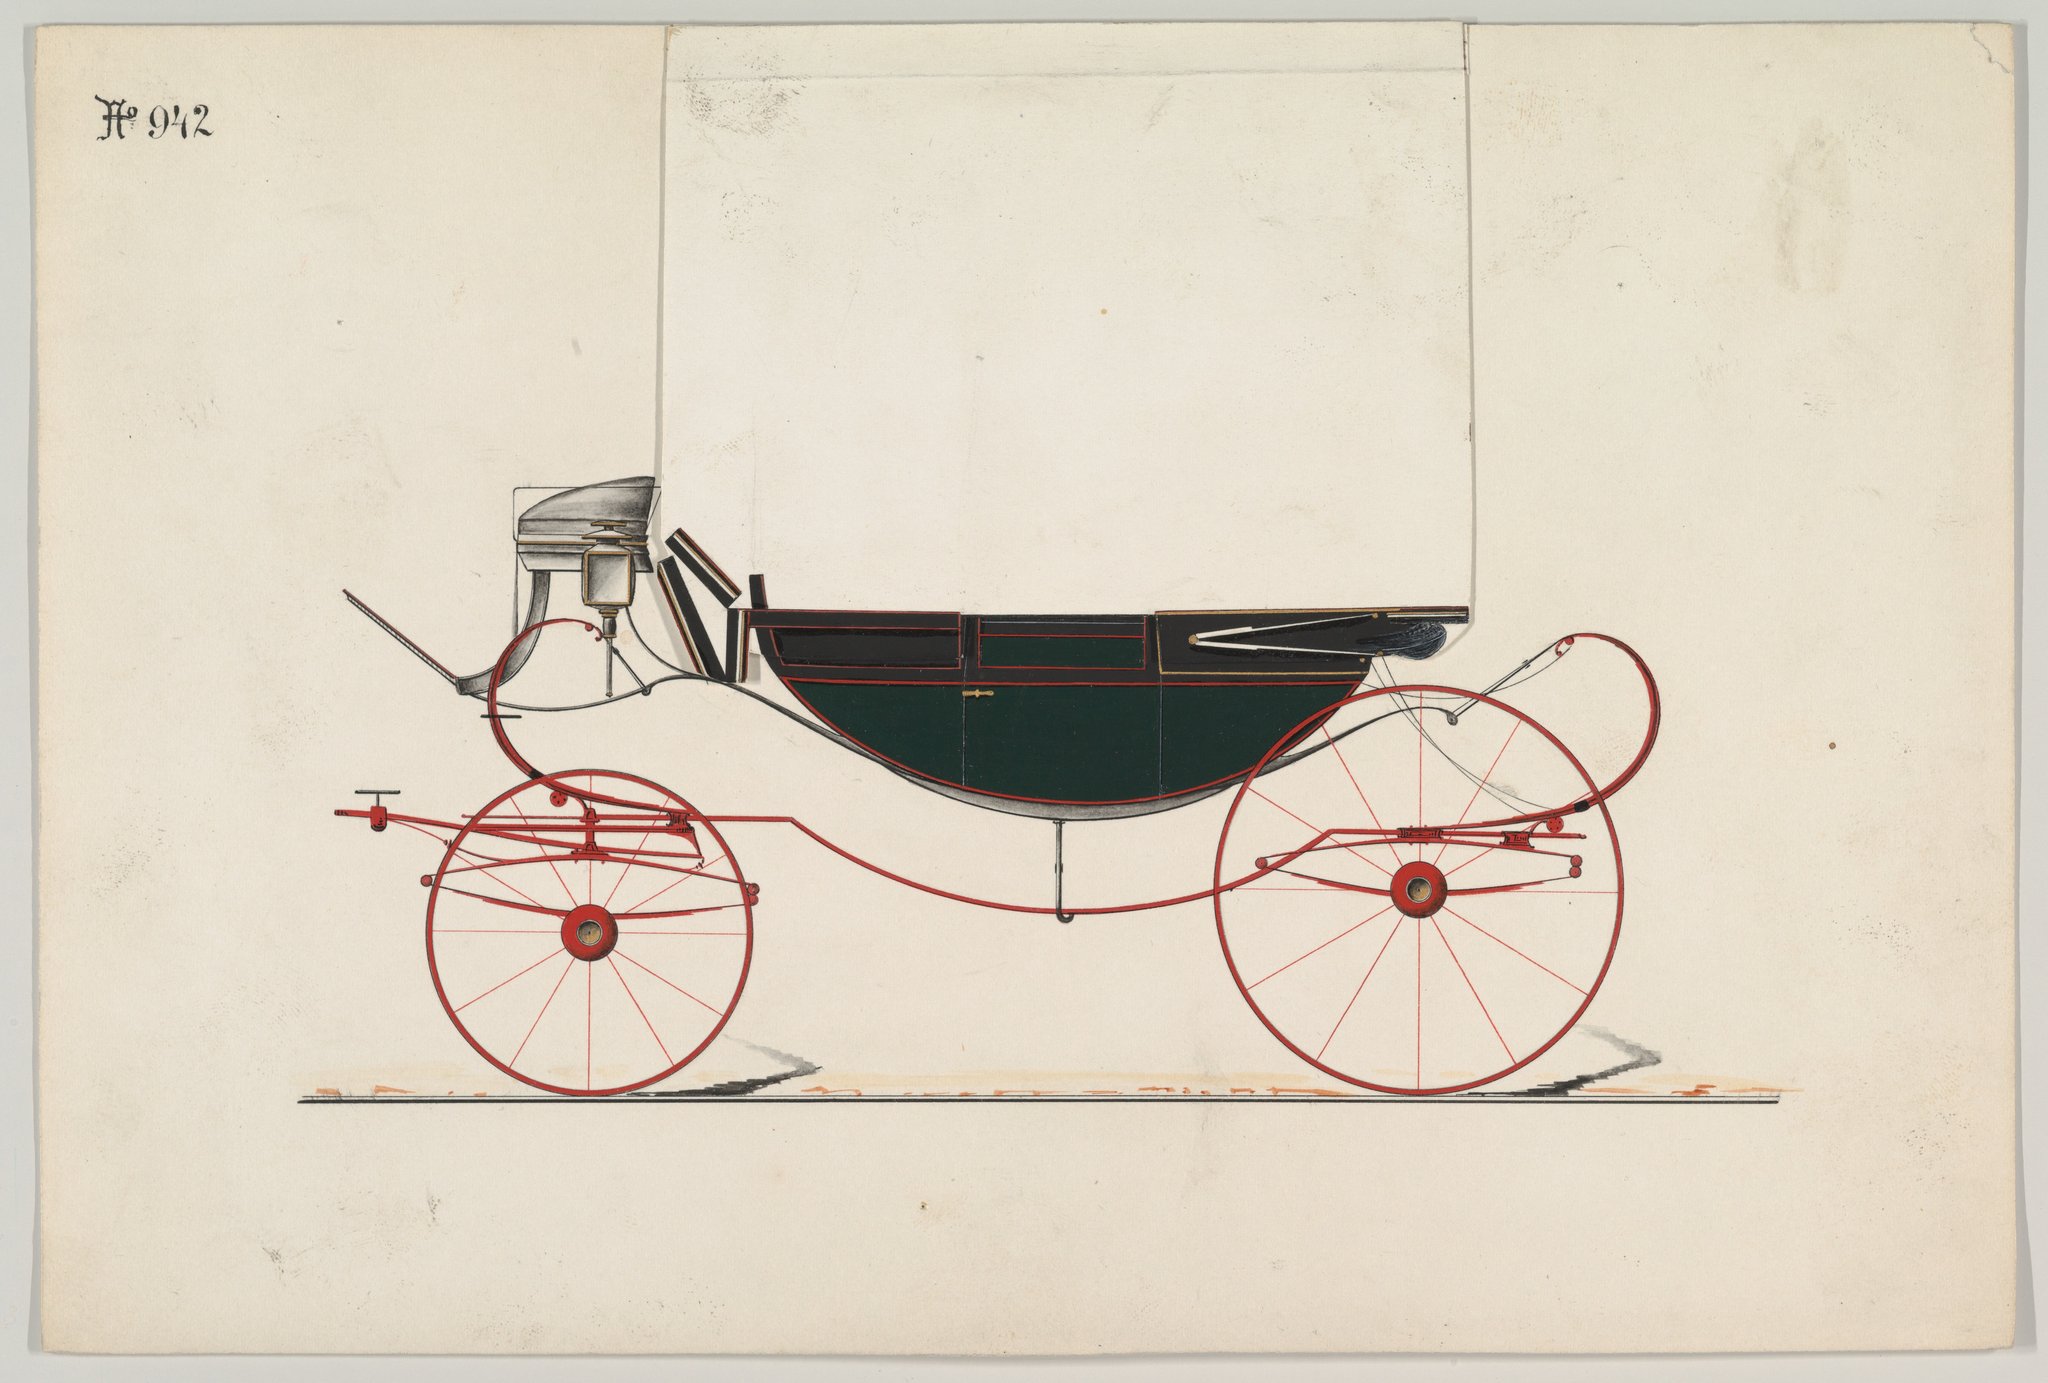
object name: drawing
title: Landau #942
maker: brewster & co.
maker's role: manufacturer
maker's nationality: american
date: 1850-1870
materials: gouache, gum arabic, ink, watercolor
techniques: pen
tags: carriages